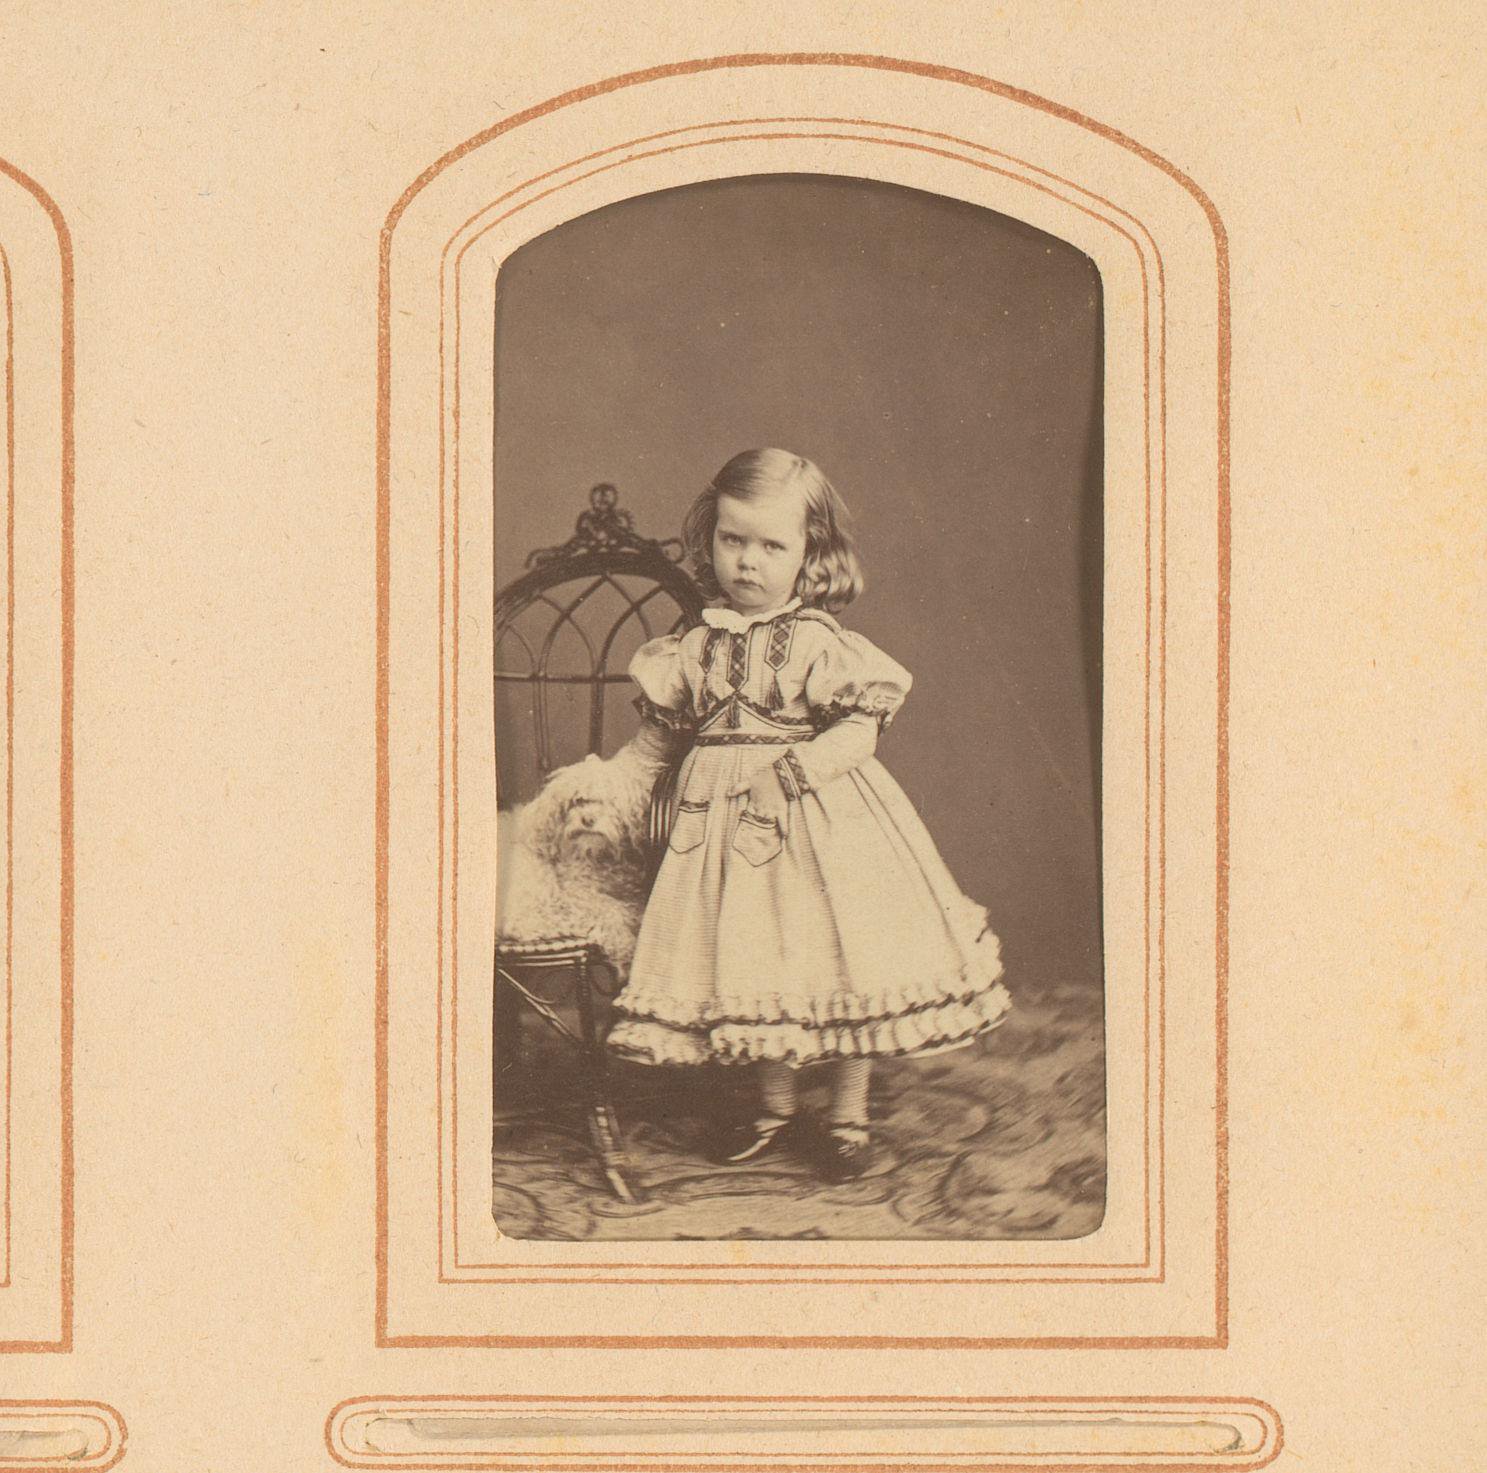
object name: album leaf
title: Portret van Anna-Lisa Hwasser met een hond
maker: matheus hansen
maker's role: fotograaf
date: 1860-1870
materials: cardboard, photographic support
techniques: albumen print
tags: historical persons, girl (child between toddler and youth), dog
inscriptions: inscription: ‘Maths Hansen/ Kongl Hof-Photograf/ Drottninggatan No. 5/ Stockholm’, annotation: ‘Anna-Lisa Hwasser/ [...] 1861/ Elise & Daniel/ Hwaser’